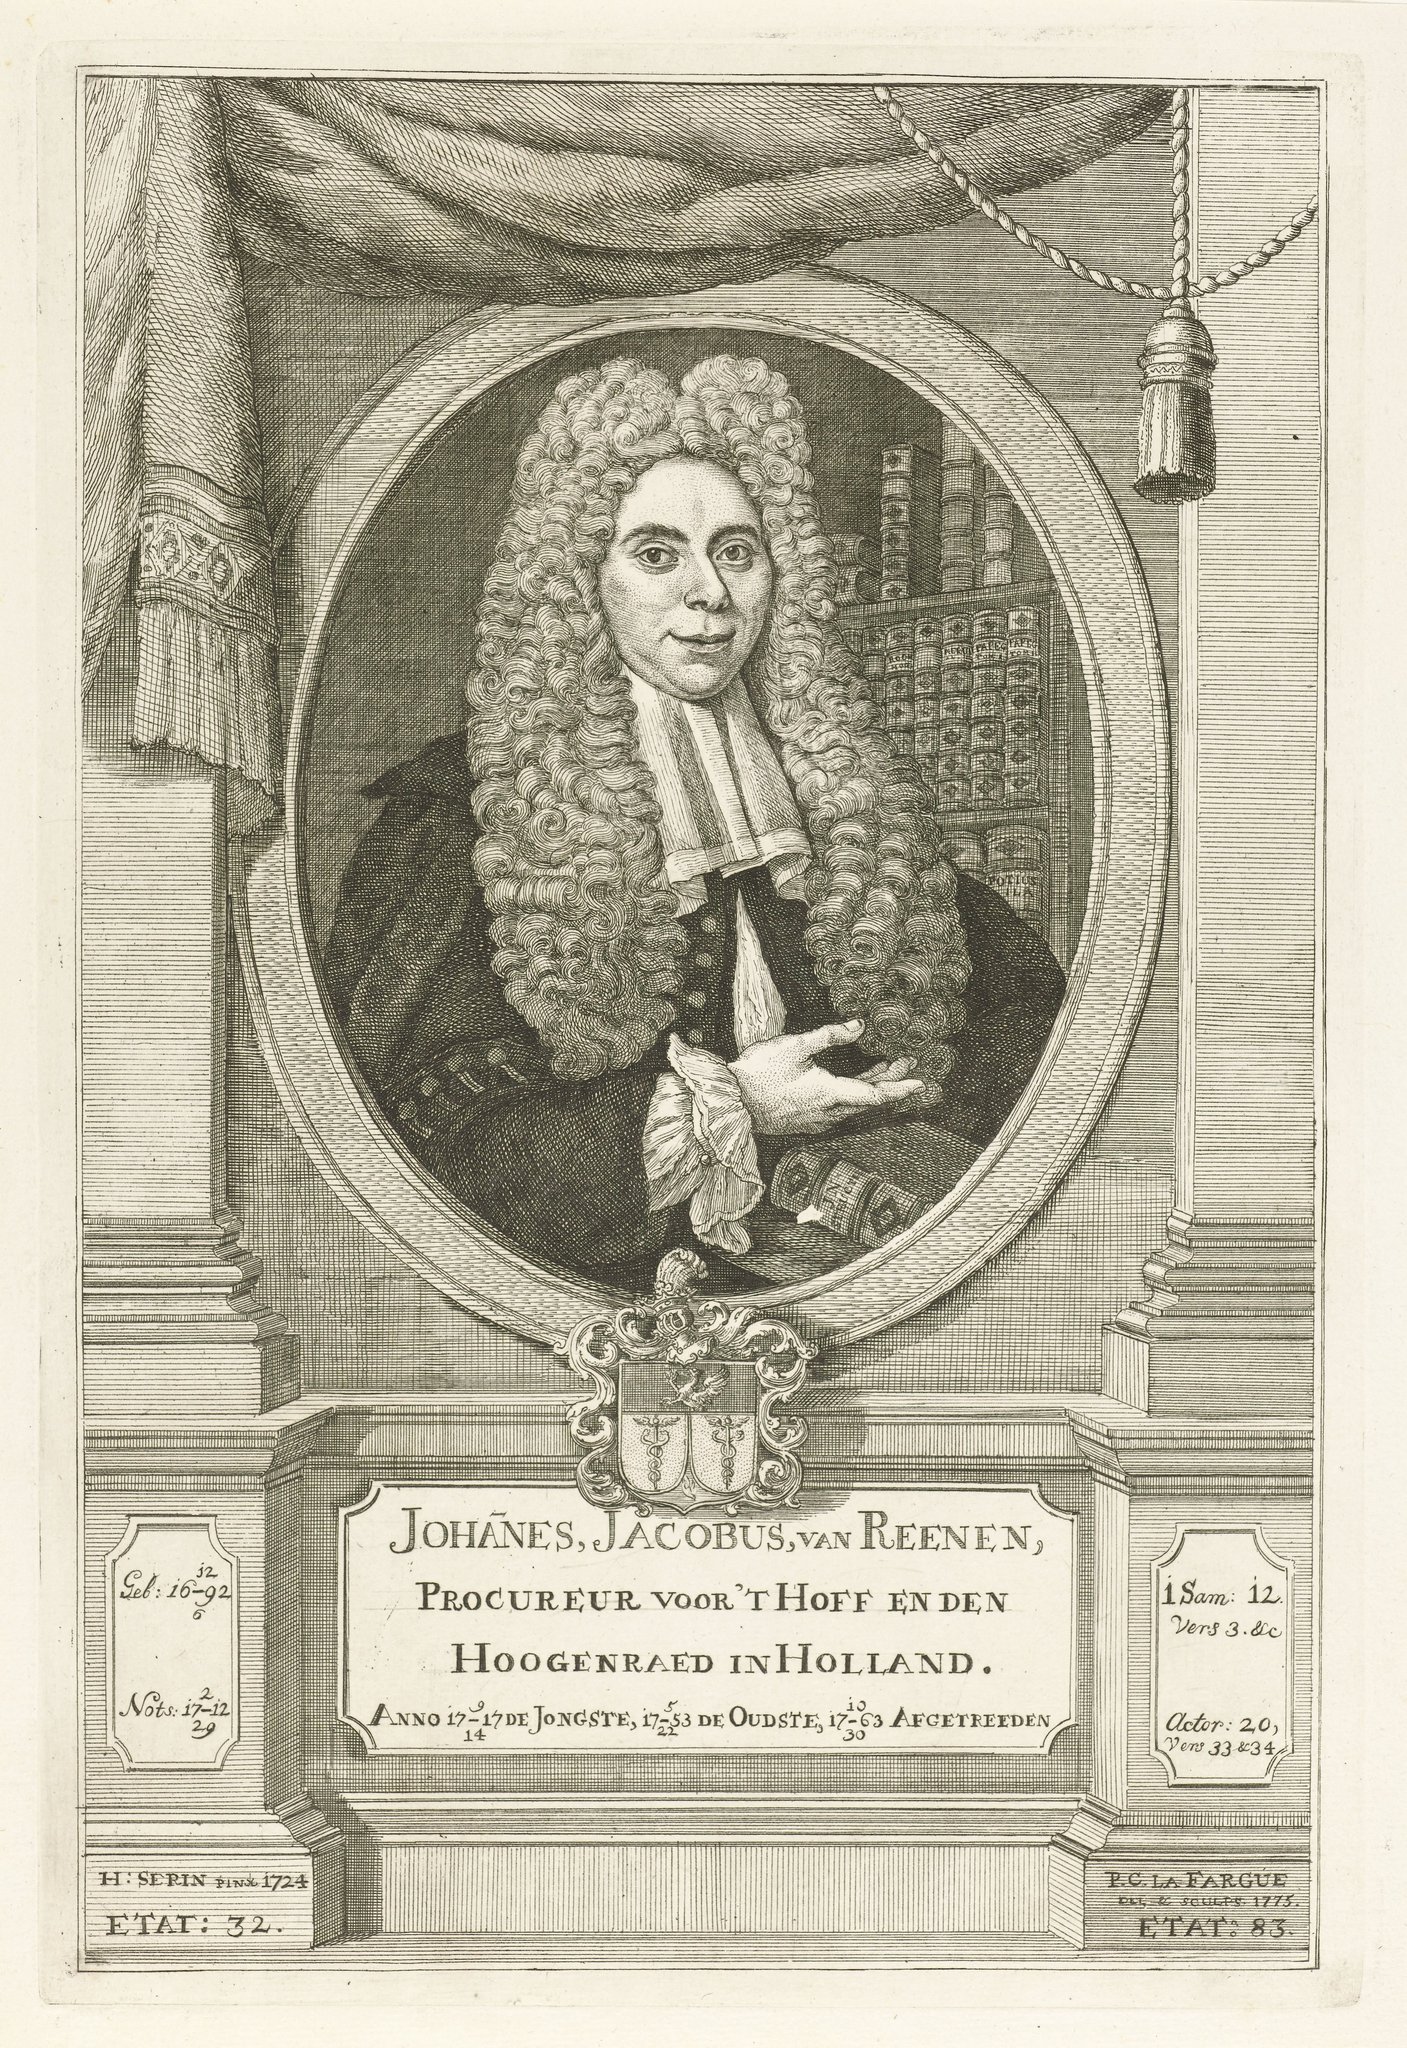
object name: print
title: Portret van Johannes Jacobus van Reenen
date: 1775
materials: paper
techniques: etching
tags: procureur, johannes jacobus van reenen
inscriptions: collector's mark: Lugt 2228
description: Portret van Johannes Jacobus van Reenen, procureur bij het Hof en de Hoge Raad van Holland.